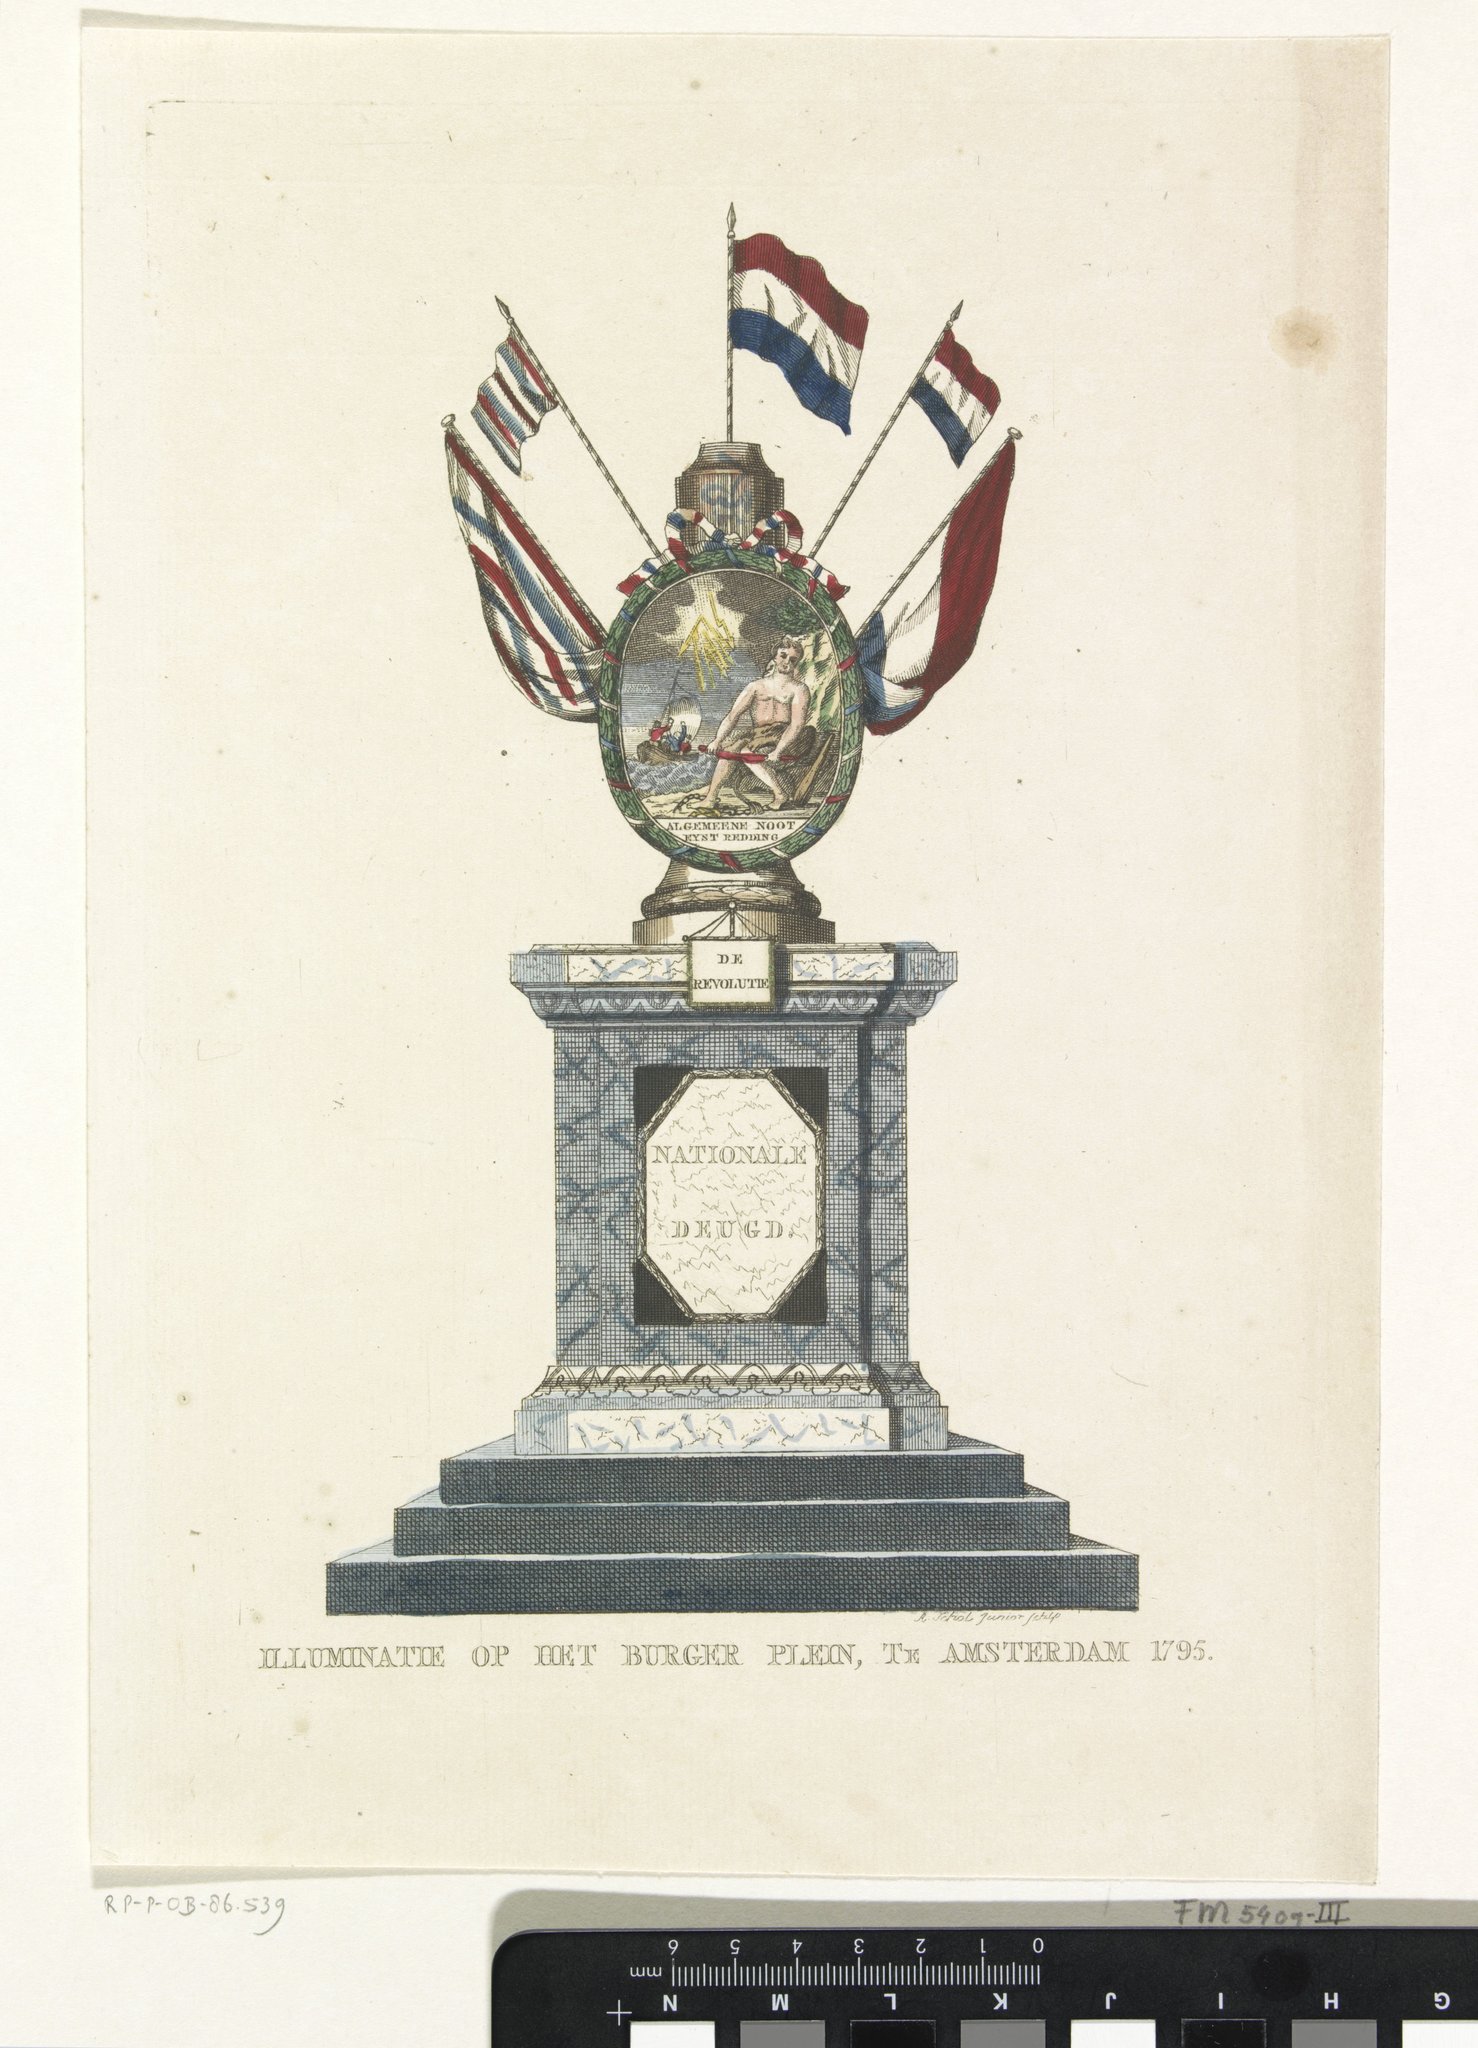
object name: print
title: De Revolutie, decoratie op het Koningsplein, 1795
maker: a. schol (ii)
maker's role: print maker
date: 1795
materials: paper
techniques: etching, hand coloring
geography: netherlands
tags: hercules as personification of some other abstract notion, festivities on events of national importance (+ festive decoration ~ festive activities), amsterdam, alliance with france (1795)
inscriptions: collector's mark: Lugt 2228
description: De Revolutie, allegorische decoratie opgericht op het Koningsplein te Amsterdam bij het Alliantiefeest op 19 juni 1795. Afgeknotte zuil met ovaal chassinet met Hercules (Bataafse dapperheid en moed) die de juk van de aristocratie breekt. Onder zijn voet vertreedt hij een kroon en ketting. Bovenaan Nederlandse en Franse vlaggen. Onderdeel van een serie van dertien platen.